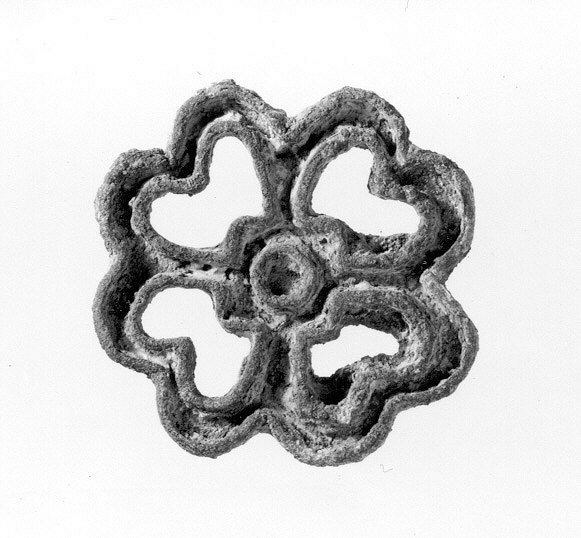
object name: stamp seal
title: Compartmented stamp seal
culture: bactria-margiana archaeological complex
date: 2333-1668 BCE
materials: copper alloy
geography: bactria-margiana